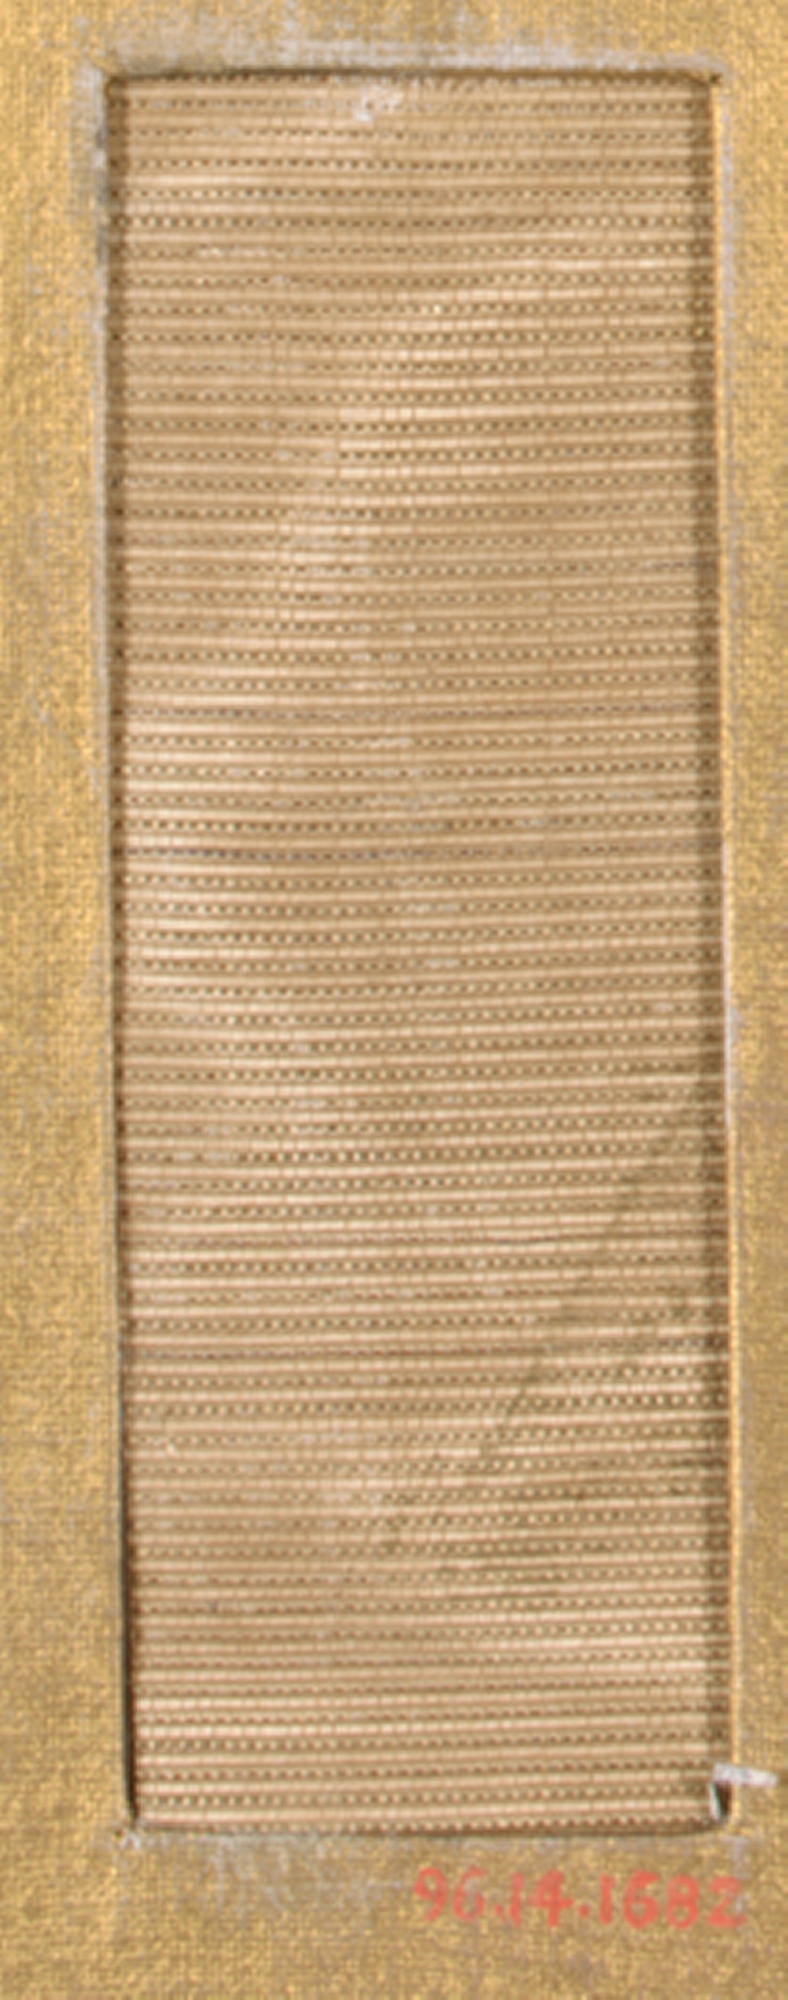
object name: piece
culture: japanese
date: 1701-1900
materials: silk